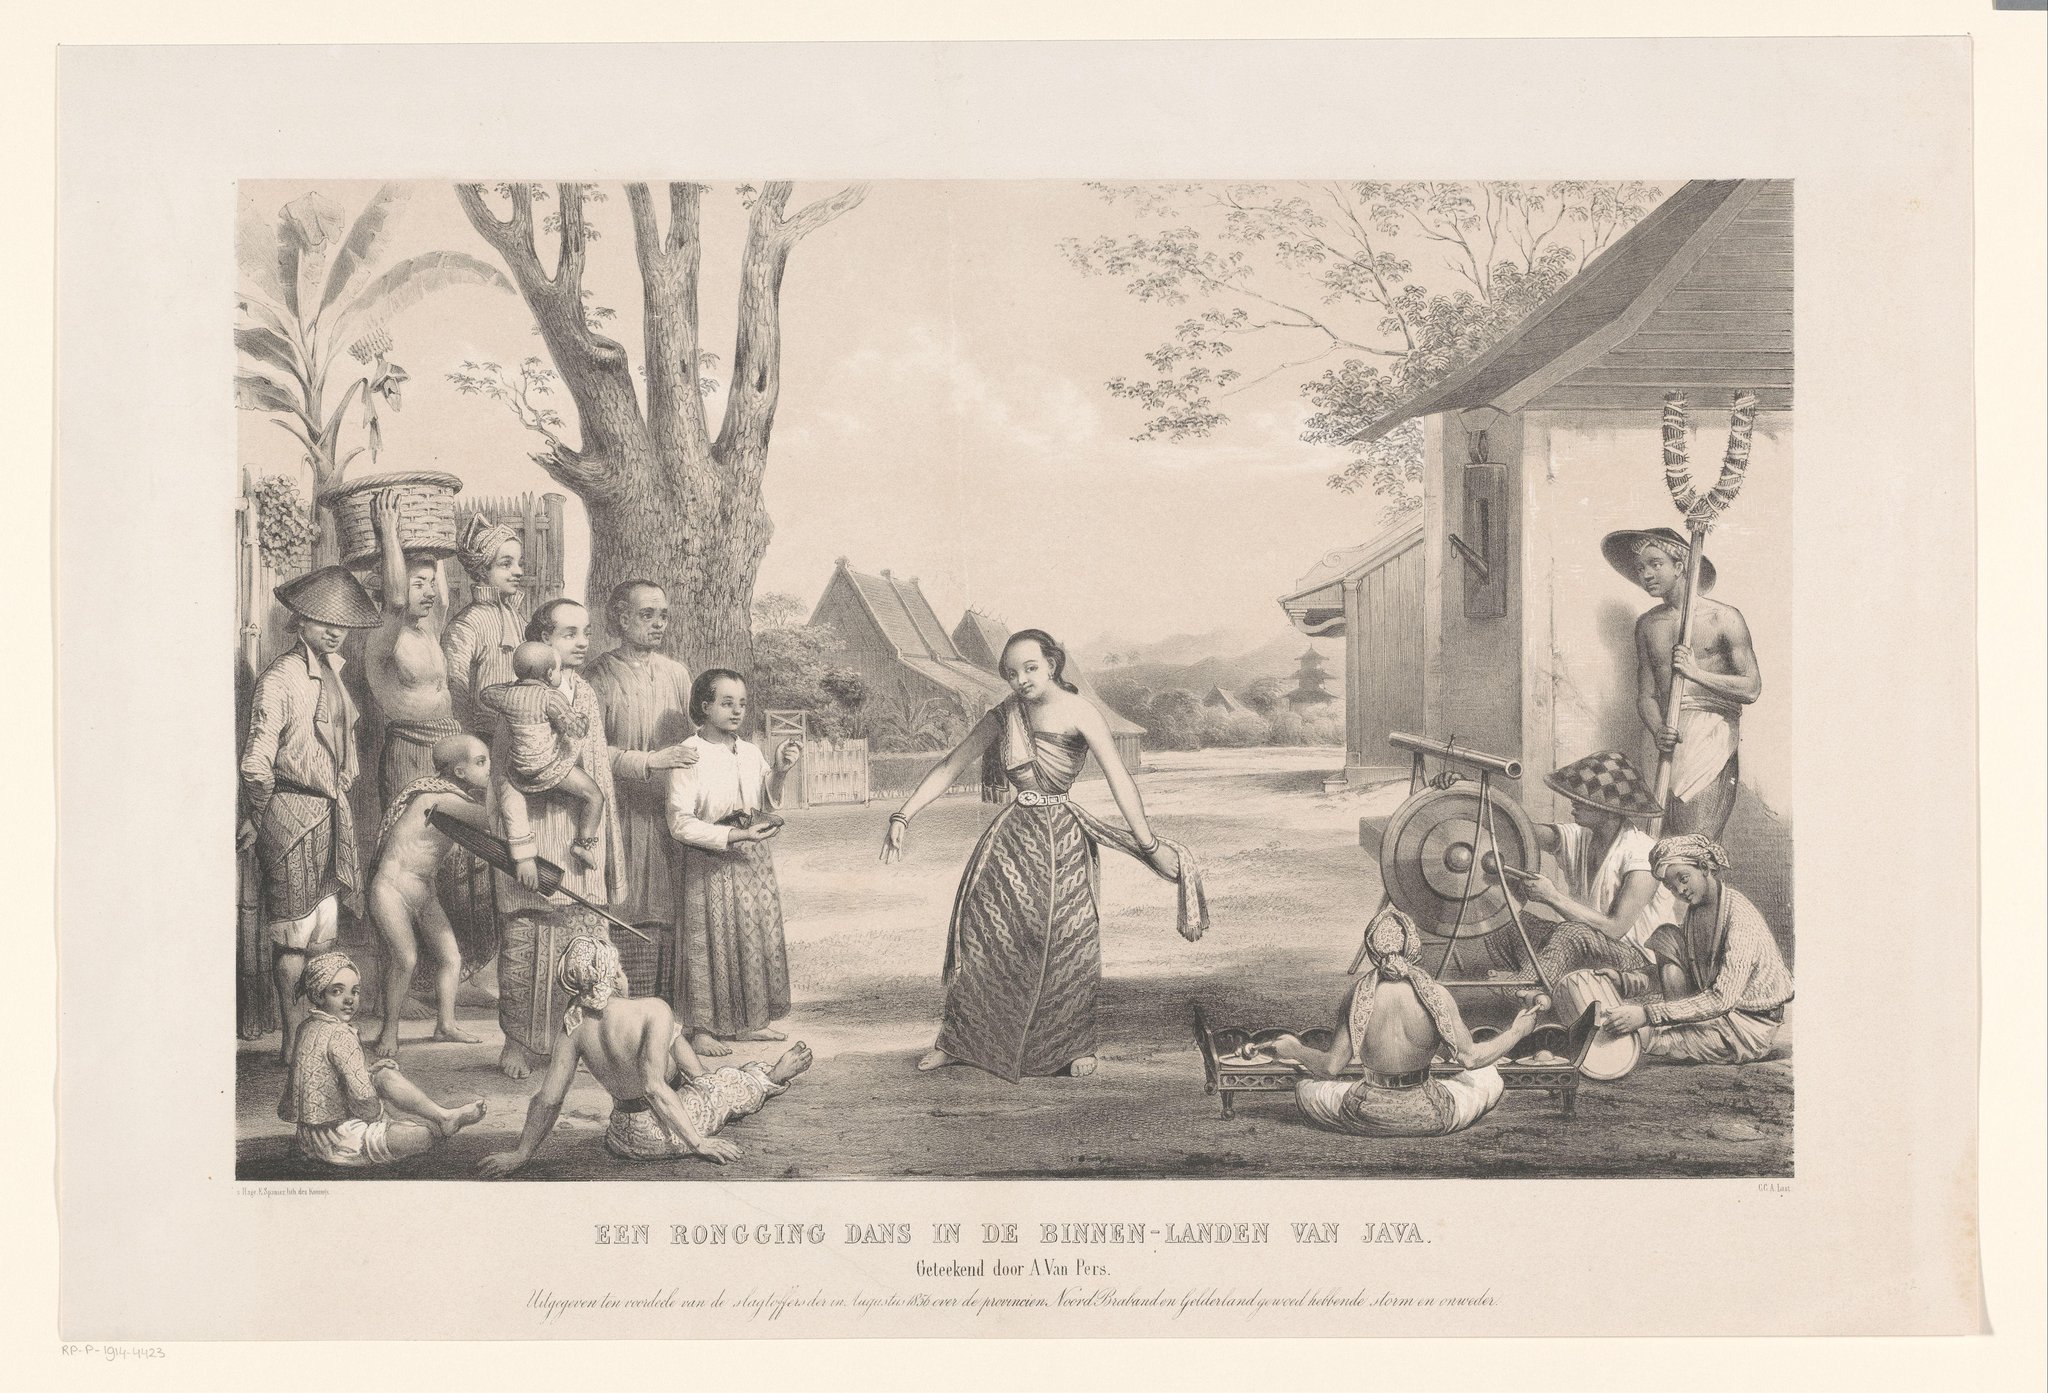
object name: print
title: Ronggeng dans te Java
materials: paper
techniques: tone lithography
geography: the hague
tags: woman dancing alone, java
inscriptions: collector's mark: Lugt 2228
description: Uitgegeven ten voordeele van de slagtoffers der in Augustus 1856 over de provincien Noord-Brabant en Gelderland gewoed hebbende storm en onweder.